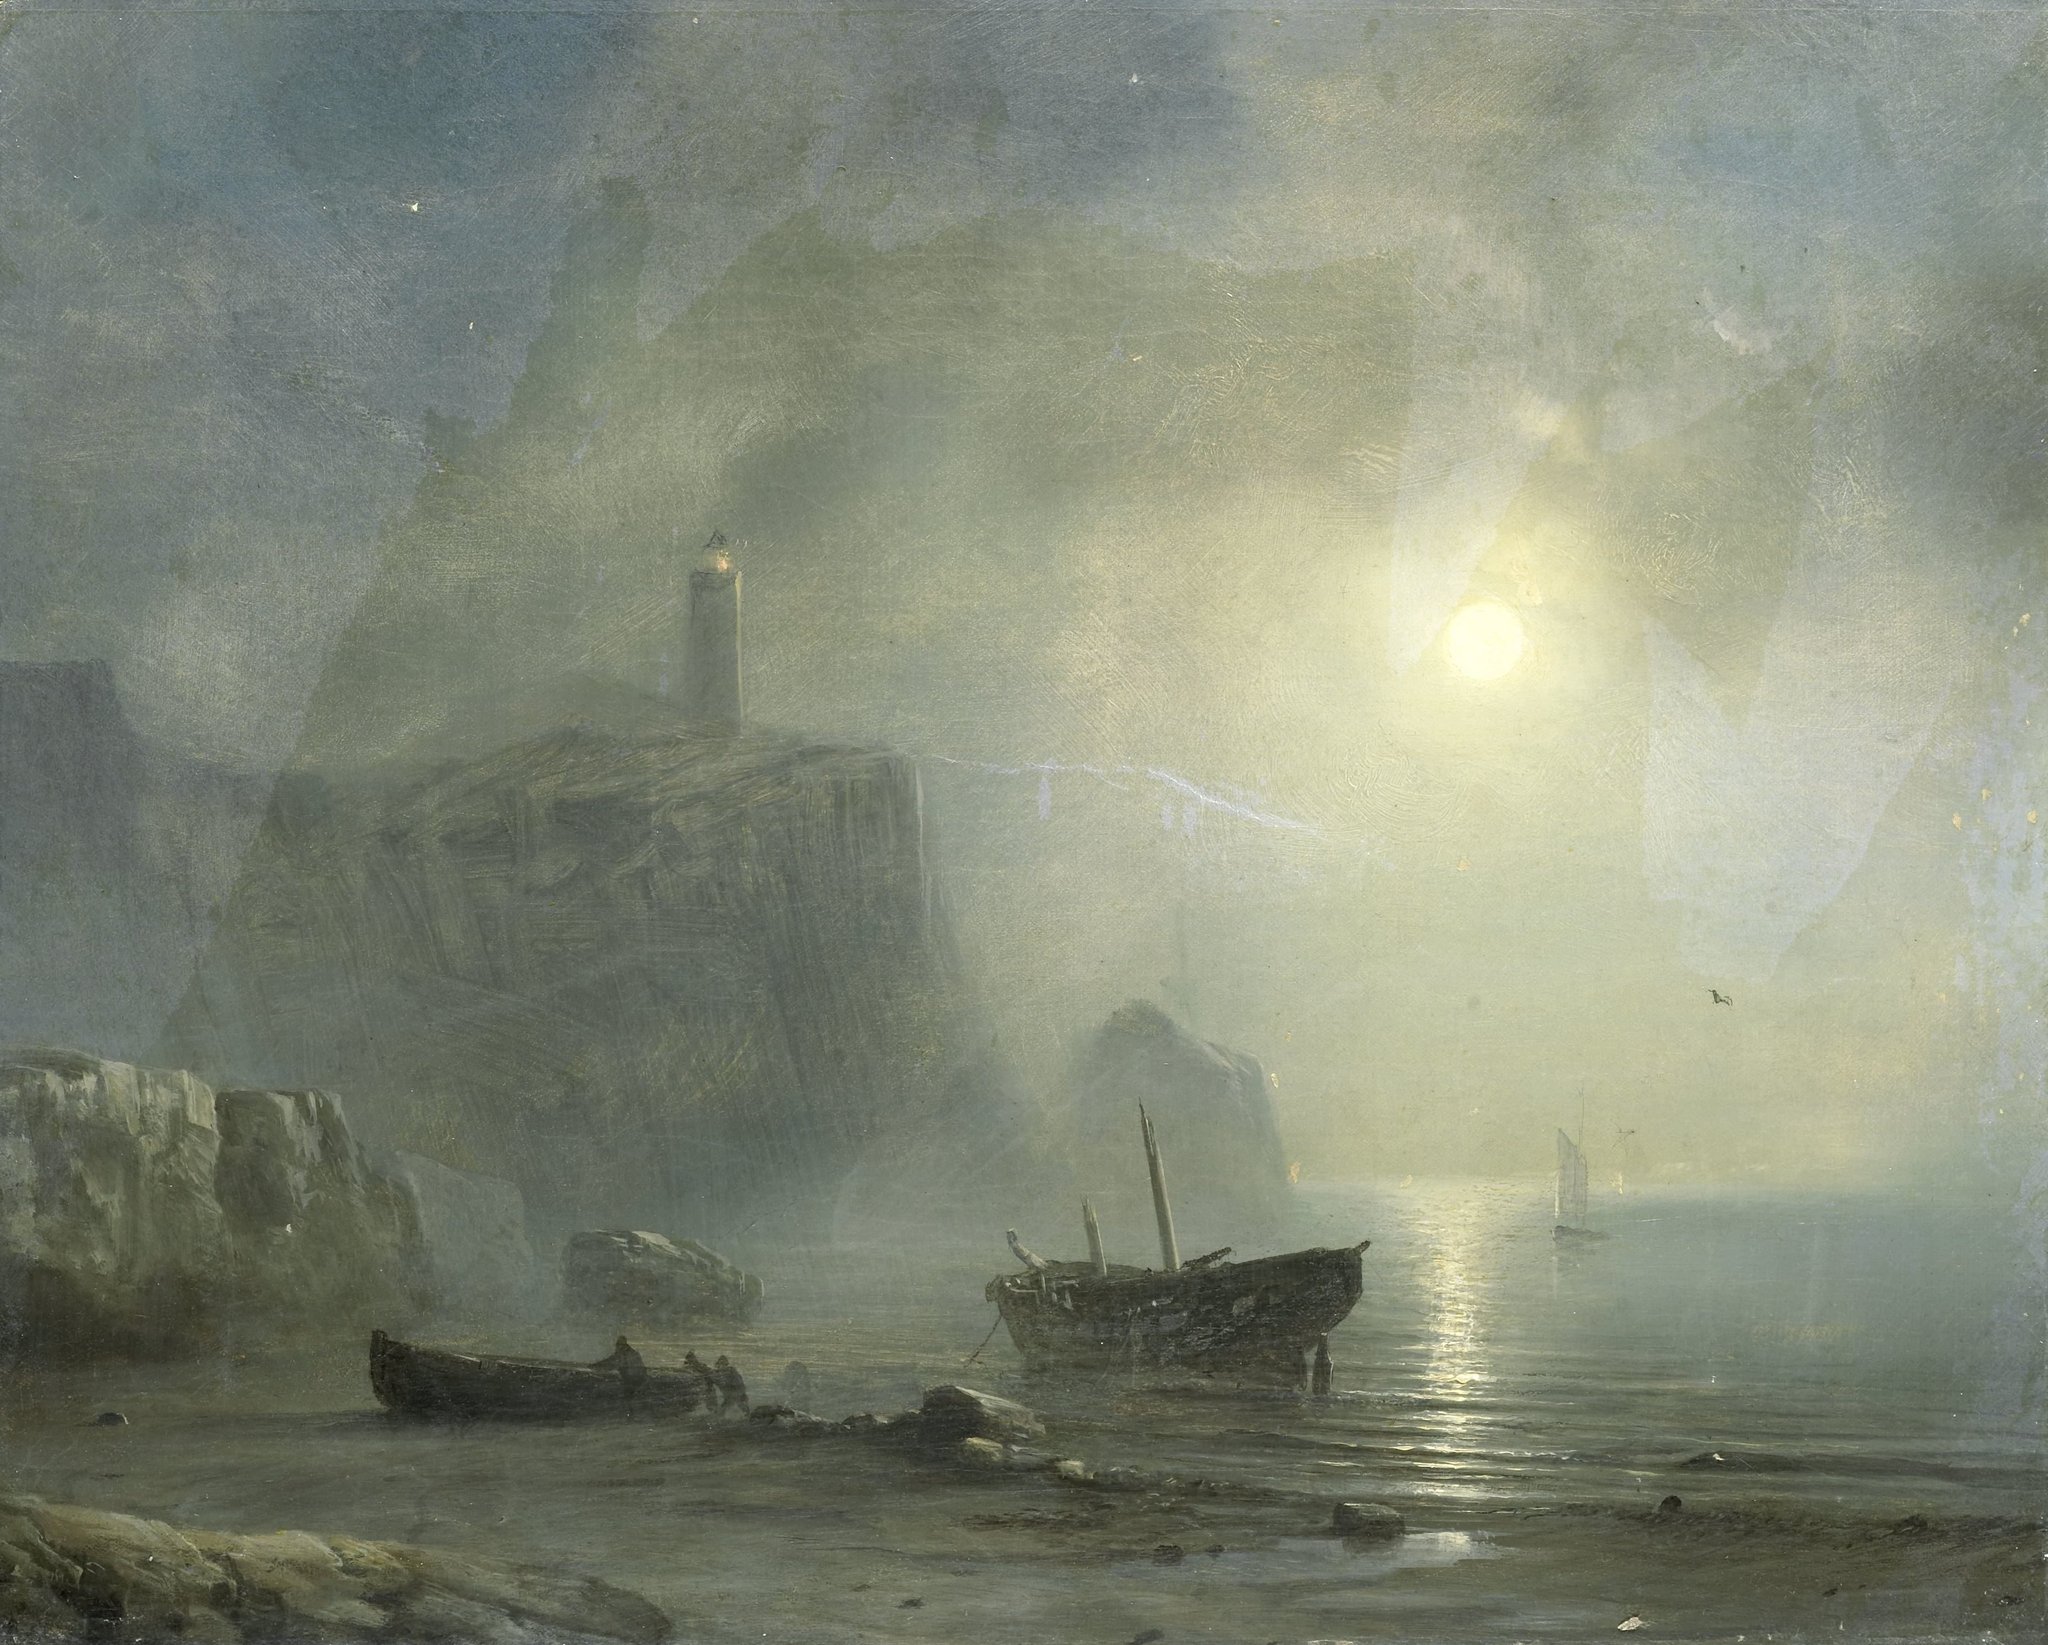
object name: painting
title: View of a Rocky Coast by Moonlight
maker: théodore gudin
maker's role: draughtsman, painter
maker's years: 1802-1880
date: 1830-1880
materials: canvas, oil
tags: lighthouse, lightship, moonlight, rocky coast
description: Gezicht op een rotsachtige kust bij maanlicht. Op de rotsen van de kust staat links een vuurtoren. Enkele mannen duwen een boot het strand op, in het water drijft vervallen vissersboot.